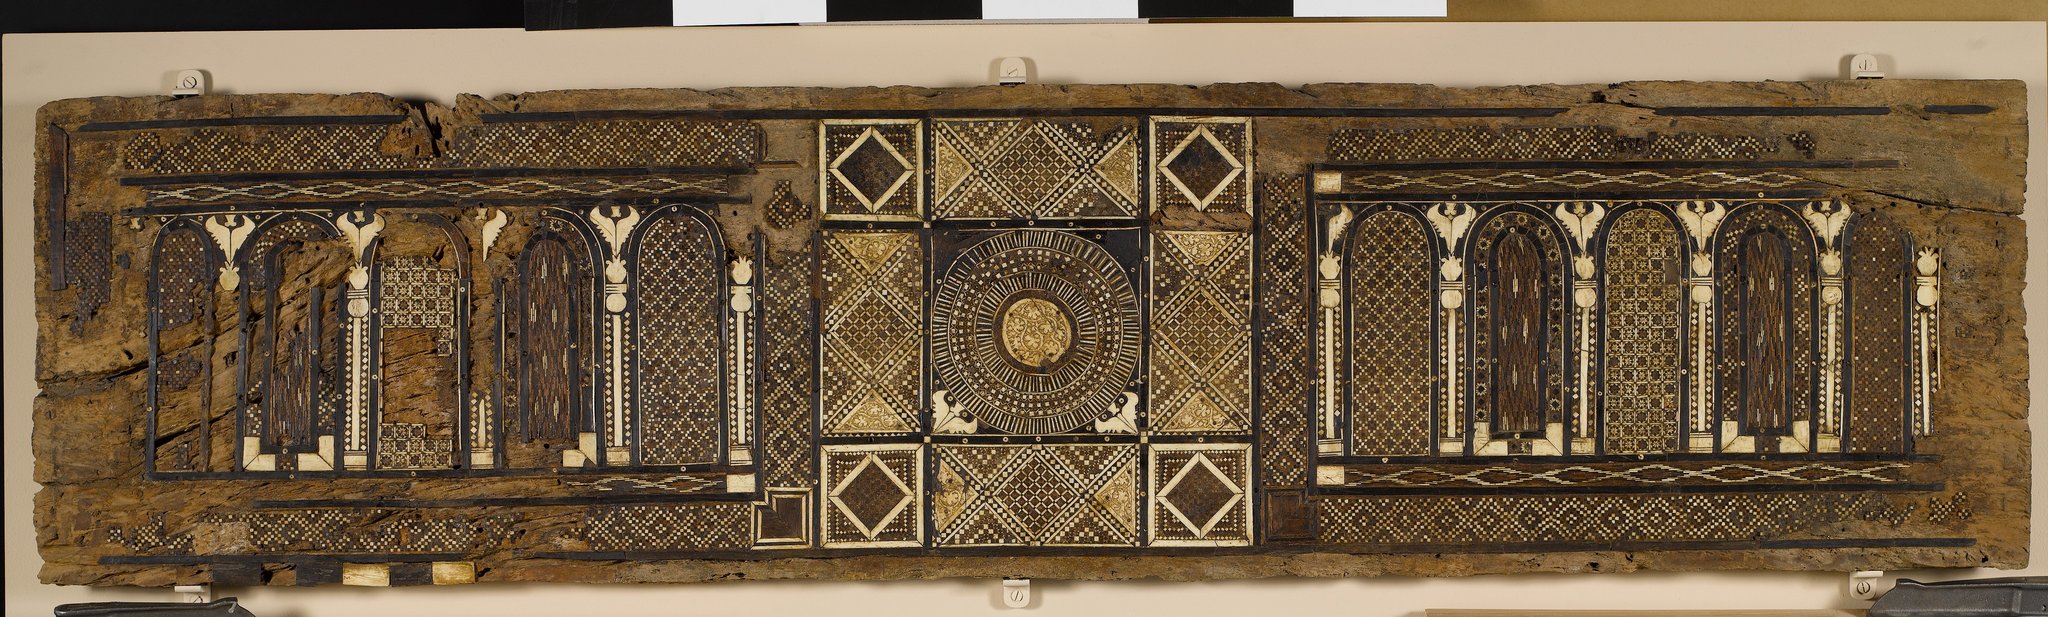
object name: panel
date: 751-800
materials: bone, wood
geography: egypt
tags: arches,columns